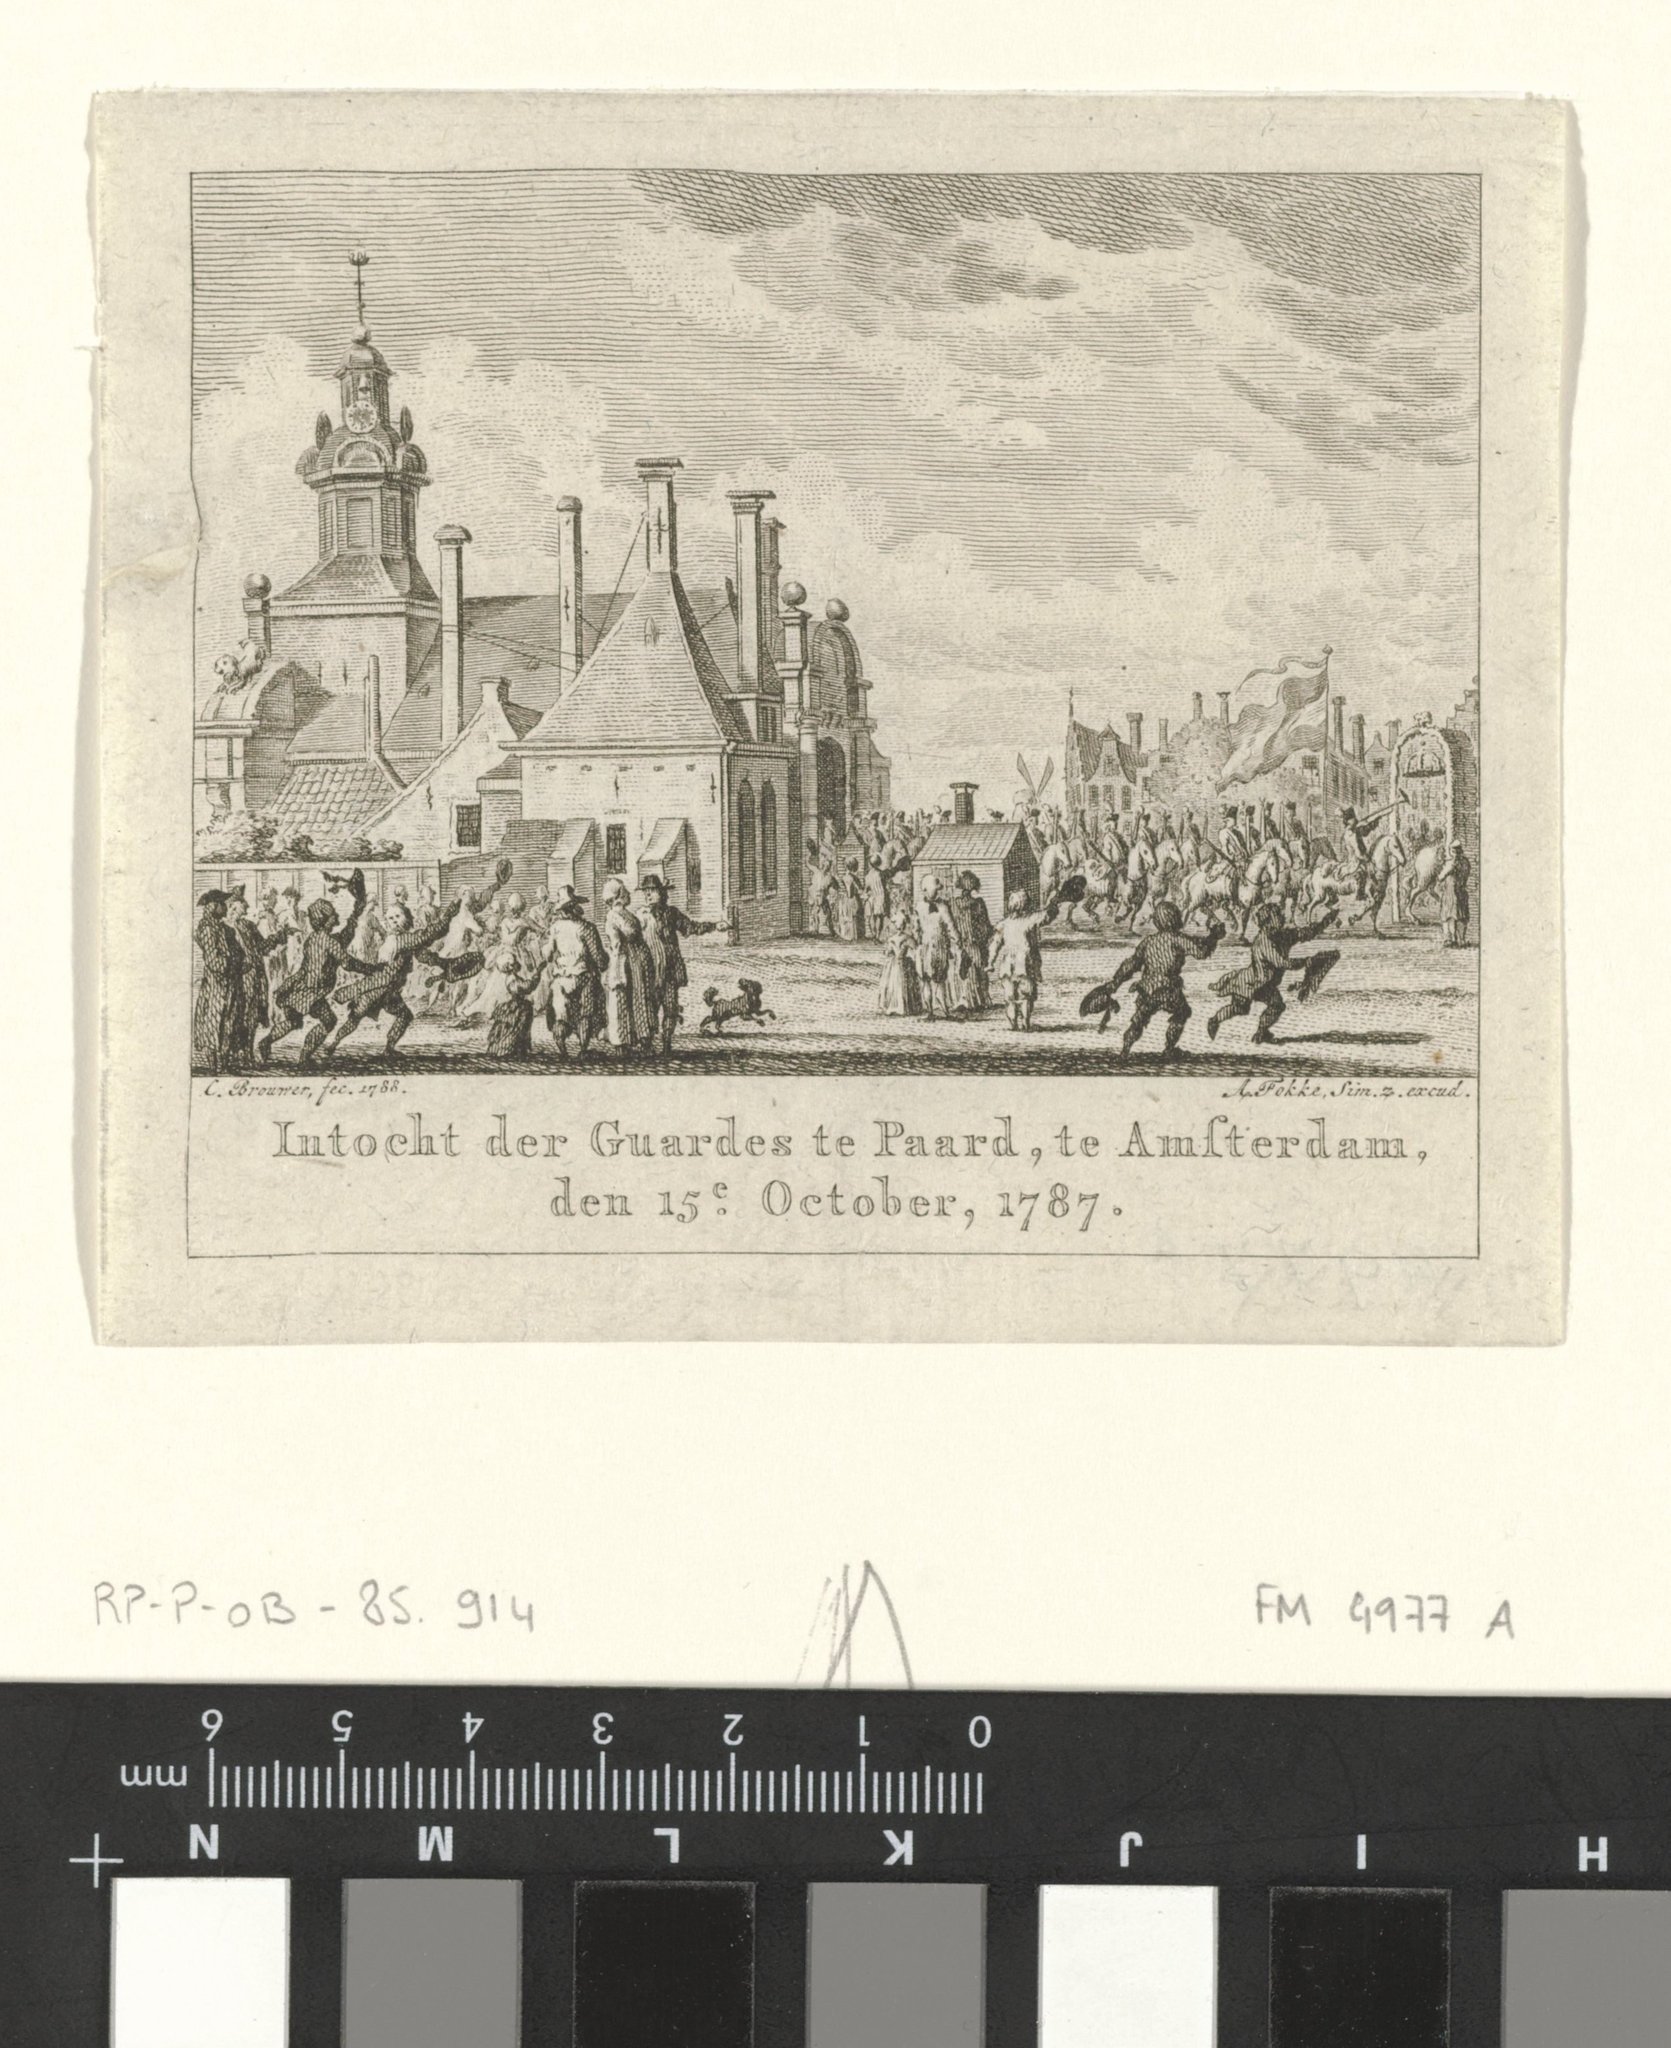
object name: print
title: Intocht der Guardes te Paard, te Amsterdam, den 15e October, 1787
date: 1787-1792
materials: paper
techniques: engraving, etching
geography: northern netherlands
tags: march into the conquered place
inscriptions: collector's mark: Lugt 2228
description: Gebruikt als illustratie in: Arend Fokke Simonsz. De vaderlandsche historie in themata. Amsterdam: Arend Fokke Simonsz., edities tussen 1783-ca. 1792.